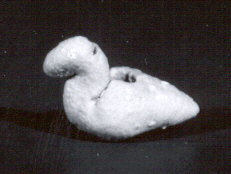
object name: ornament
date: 2333-2001 BCE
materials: faience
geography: mesopotamia